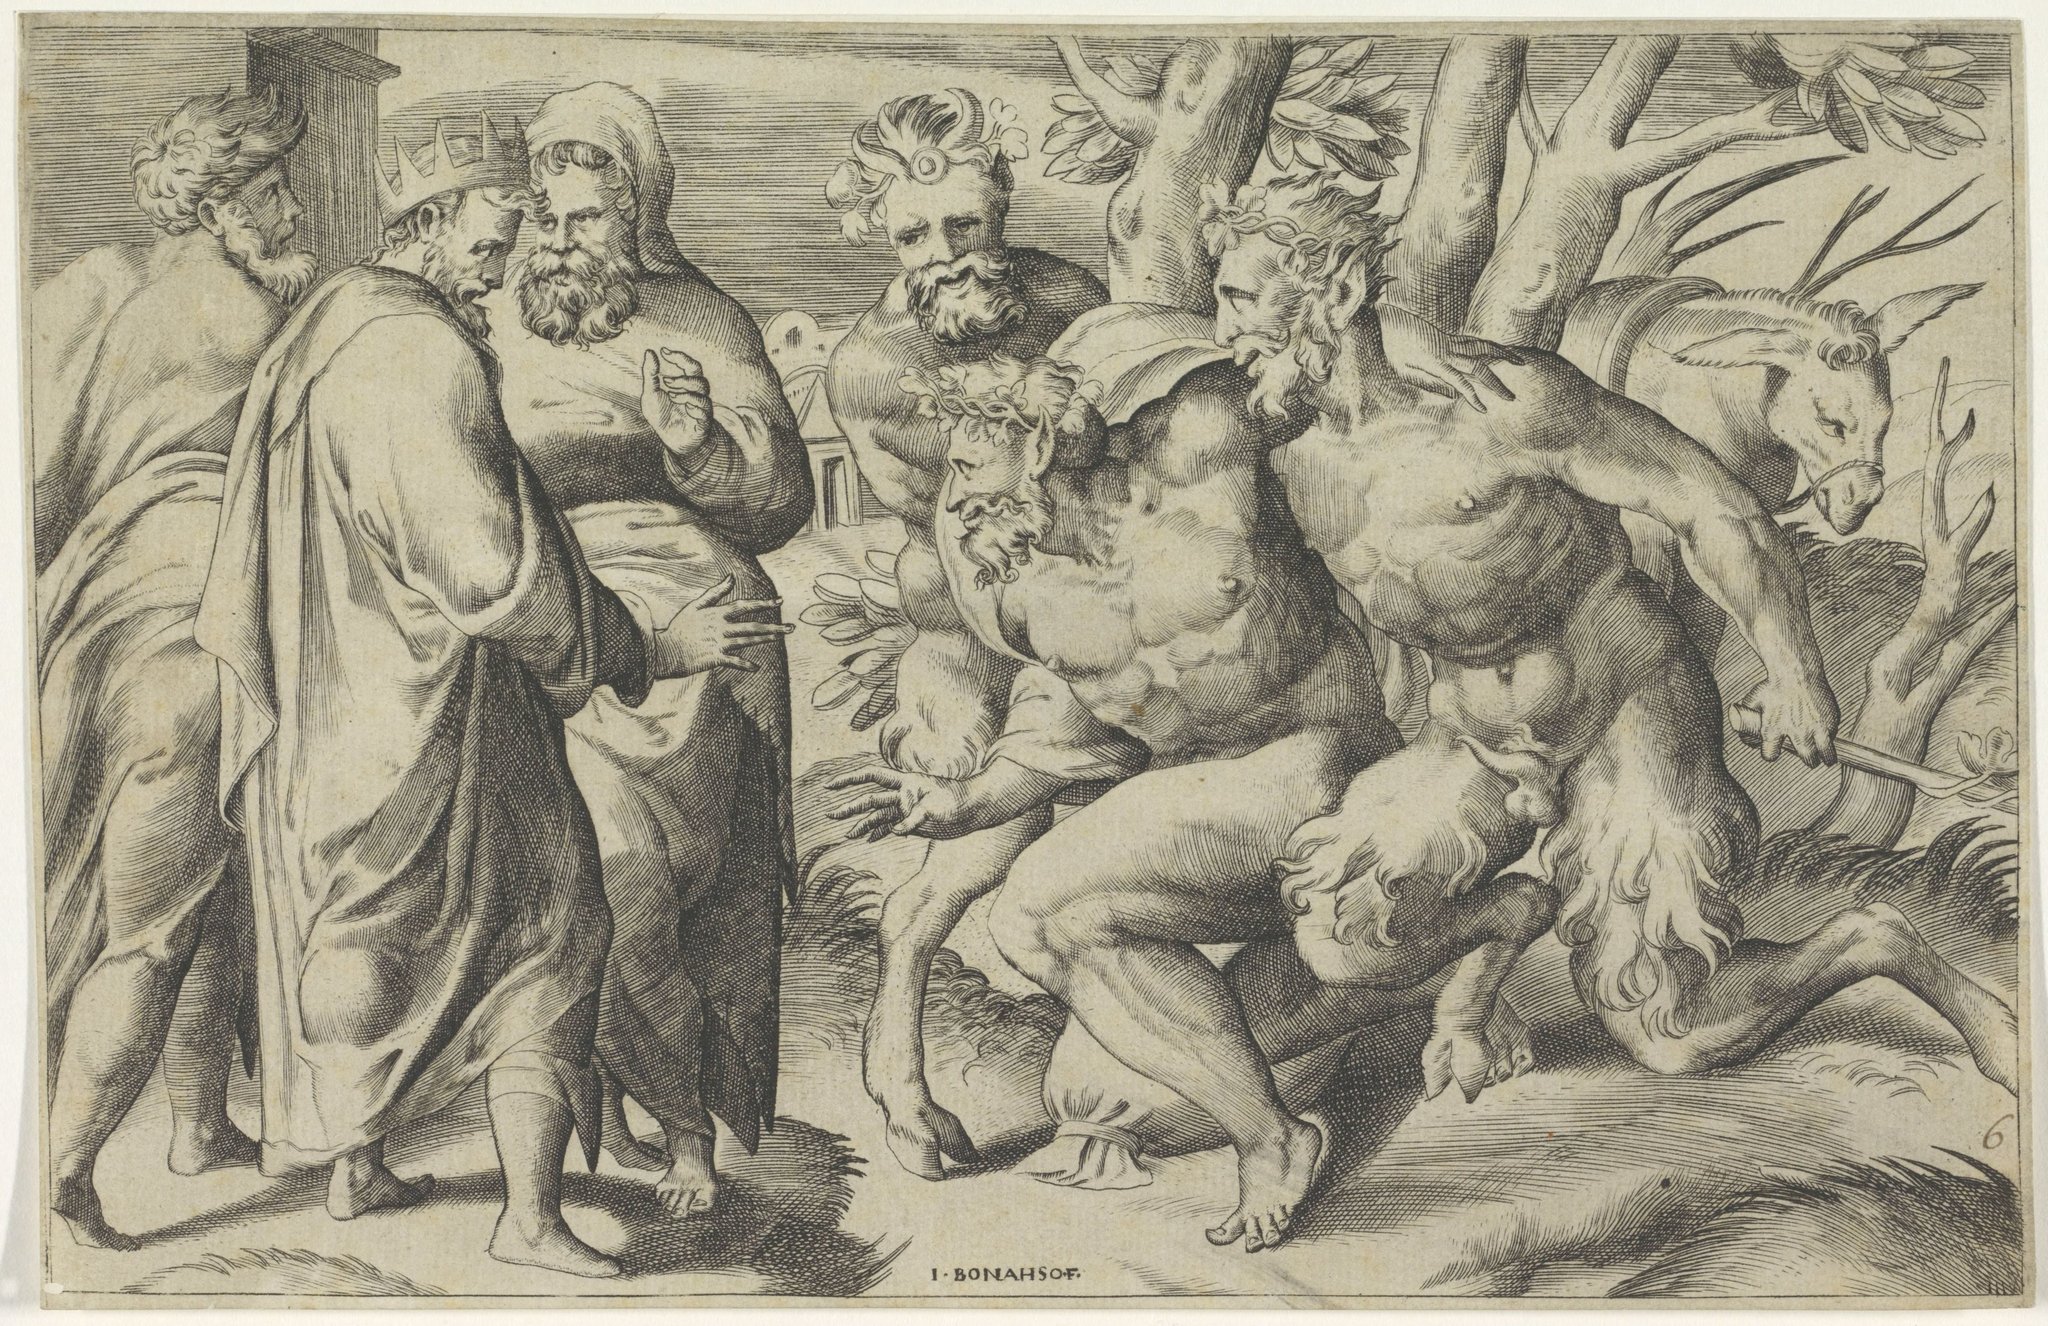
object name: print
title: Twee saters brengen Silenus bij koning Midas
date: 1501-1580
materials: paper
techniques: engraving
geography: italy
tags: satyr(s) (in general), silenus amicably entertained by midas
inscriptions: number: ‘6’, collector's mark: Lugt 11, collector's mark: Lugt 10, collector's mark: ‘Hinloopen’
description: Blanco ondermarge afgesneden. Mogelijk naar een tekening door Perino del Vaga naar een antiek reliëf.